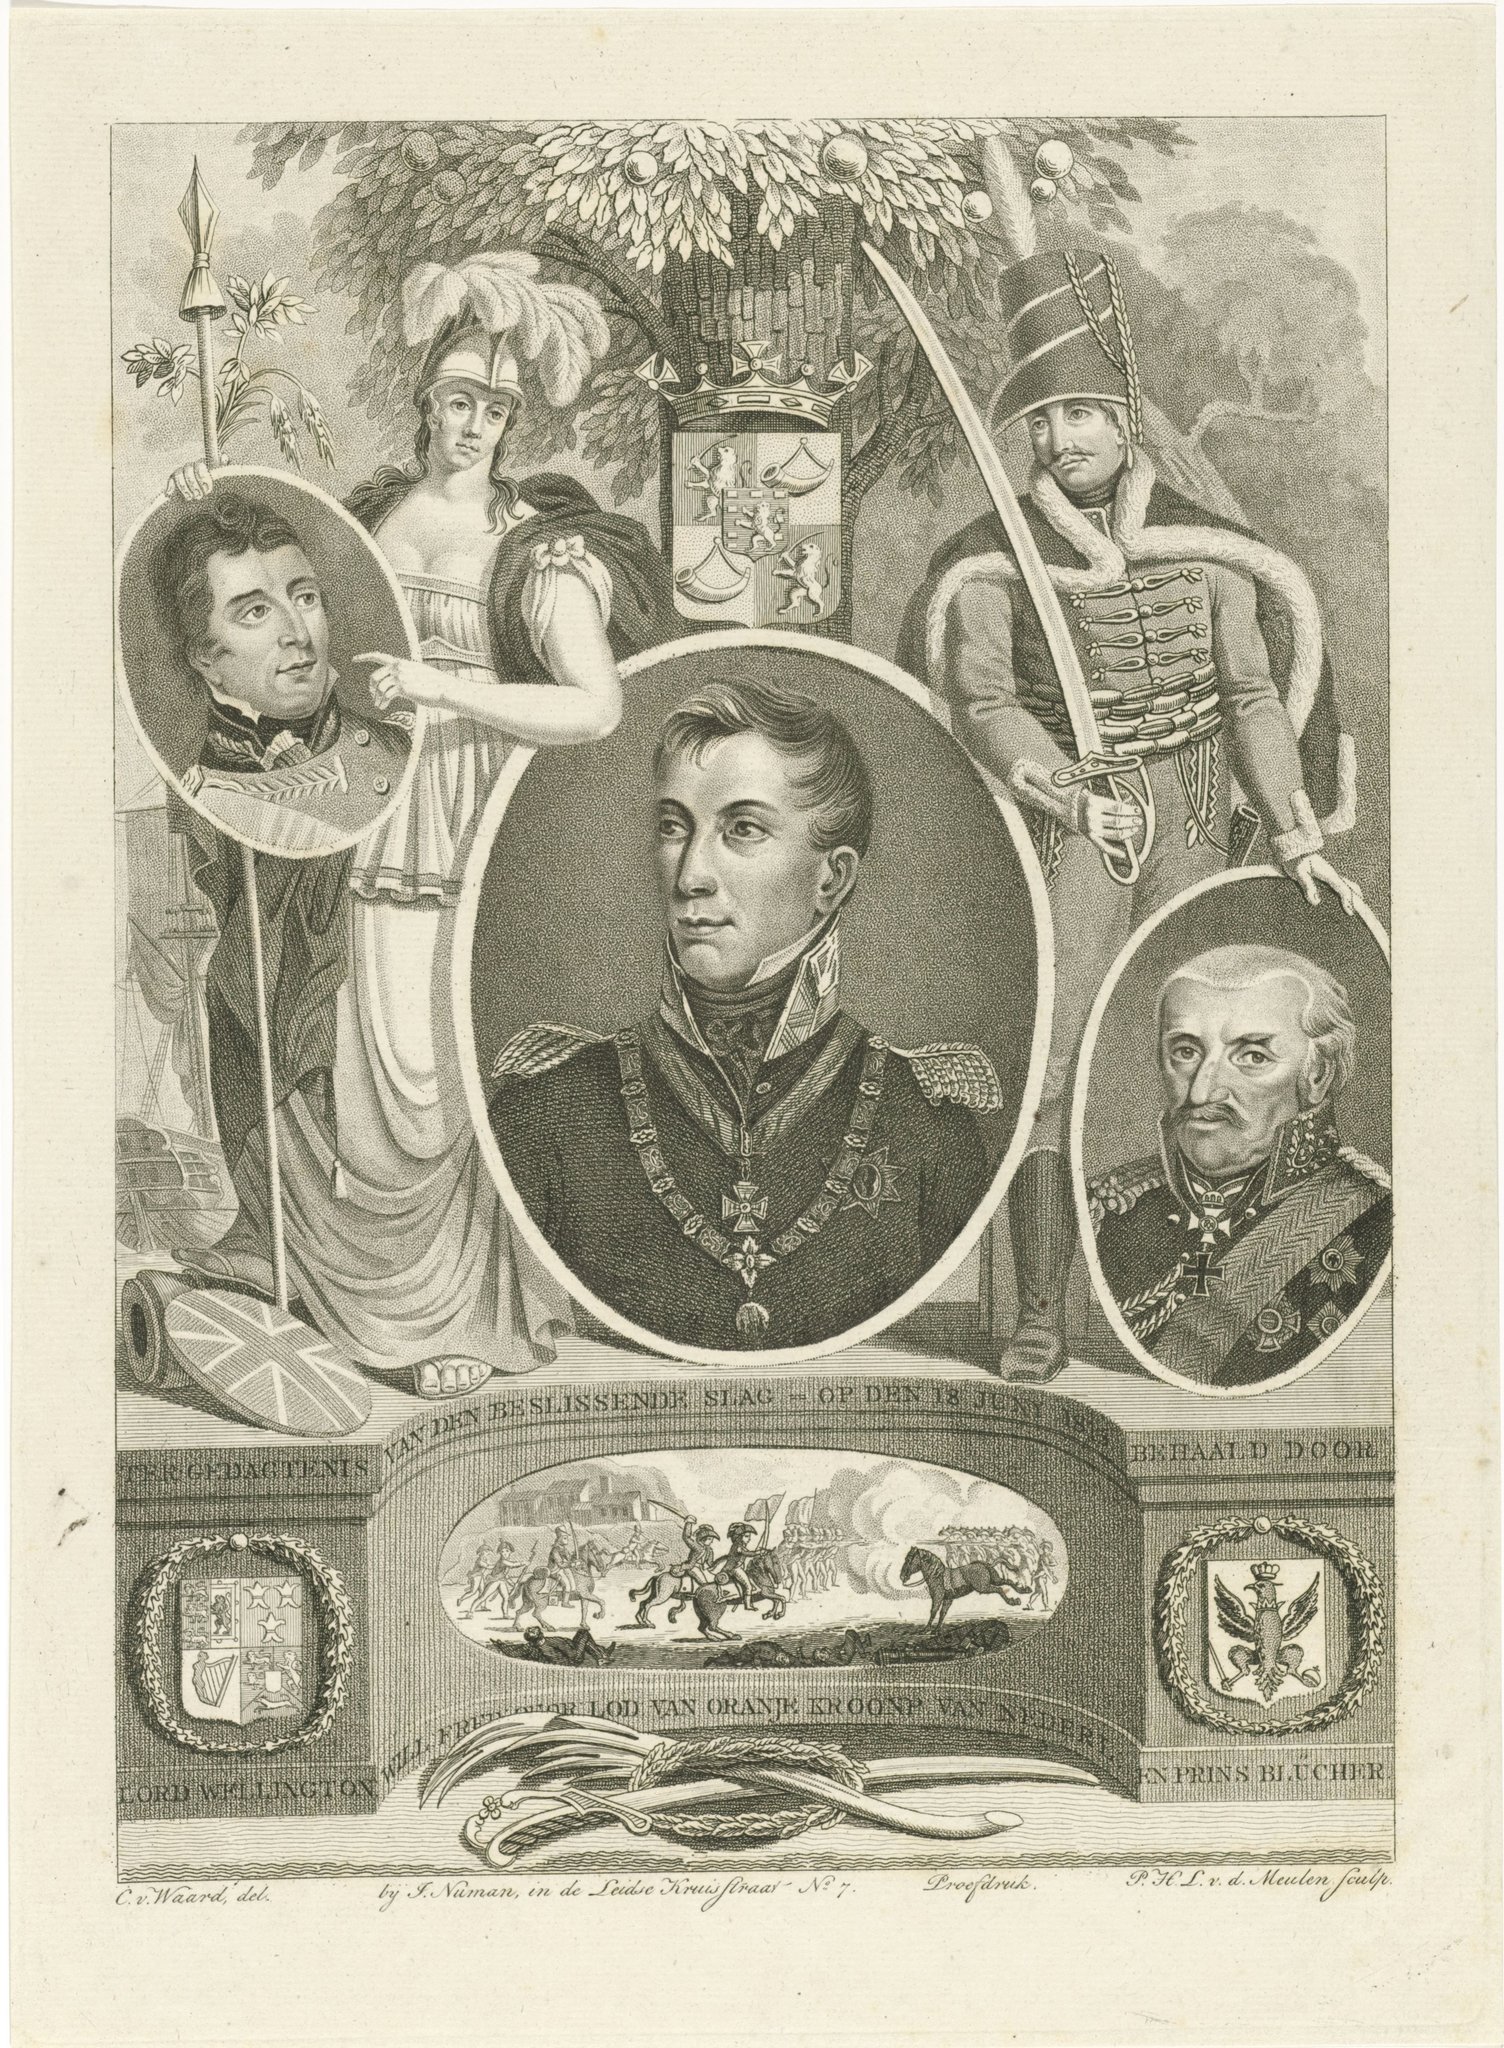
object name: print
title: Portret van kroonprins Willem Frederik George Lodewijk ter nagedachtenis van de Slag bij Waterloo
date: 1815-1817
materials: paper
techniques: stippled etching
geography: amsterdam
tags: the hague, william ii of the netherlands, walmer castle, arthur wellesley of wellington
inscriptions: collector's mark: Lugt 2228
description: Portret van kroonprins Willem Frederik George Lodewijk ter nagedachtenis van de Slag bij Waterloo. Naast het portret toont Minerva het portret van de hertog van Wellington en toont een officier het portret van Gebhard Leberecht Blücher von Wahlstatt. Midden op het basement de Slag bij Waterloo, waarin zij vochten.